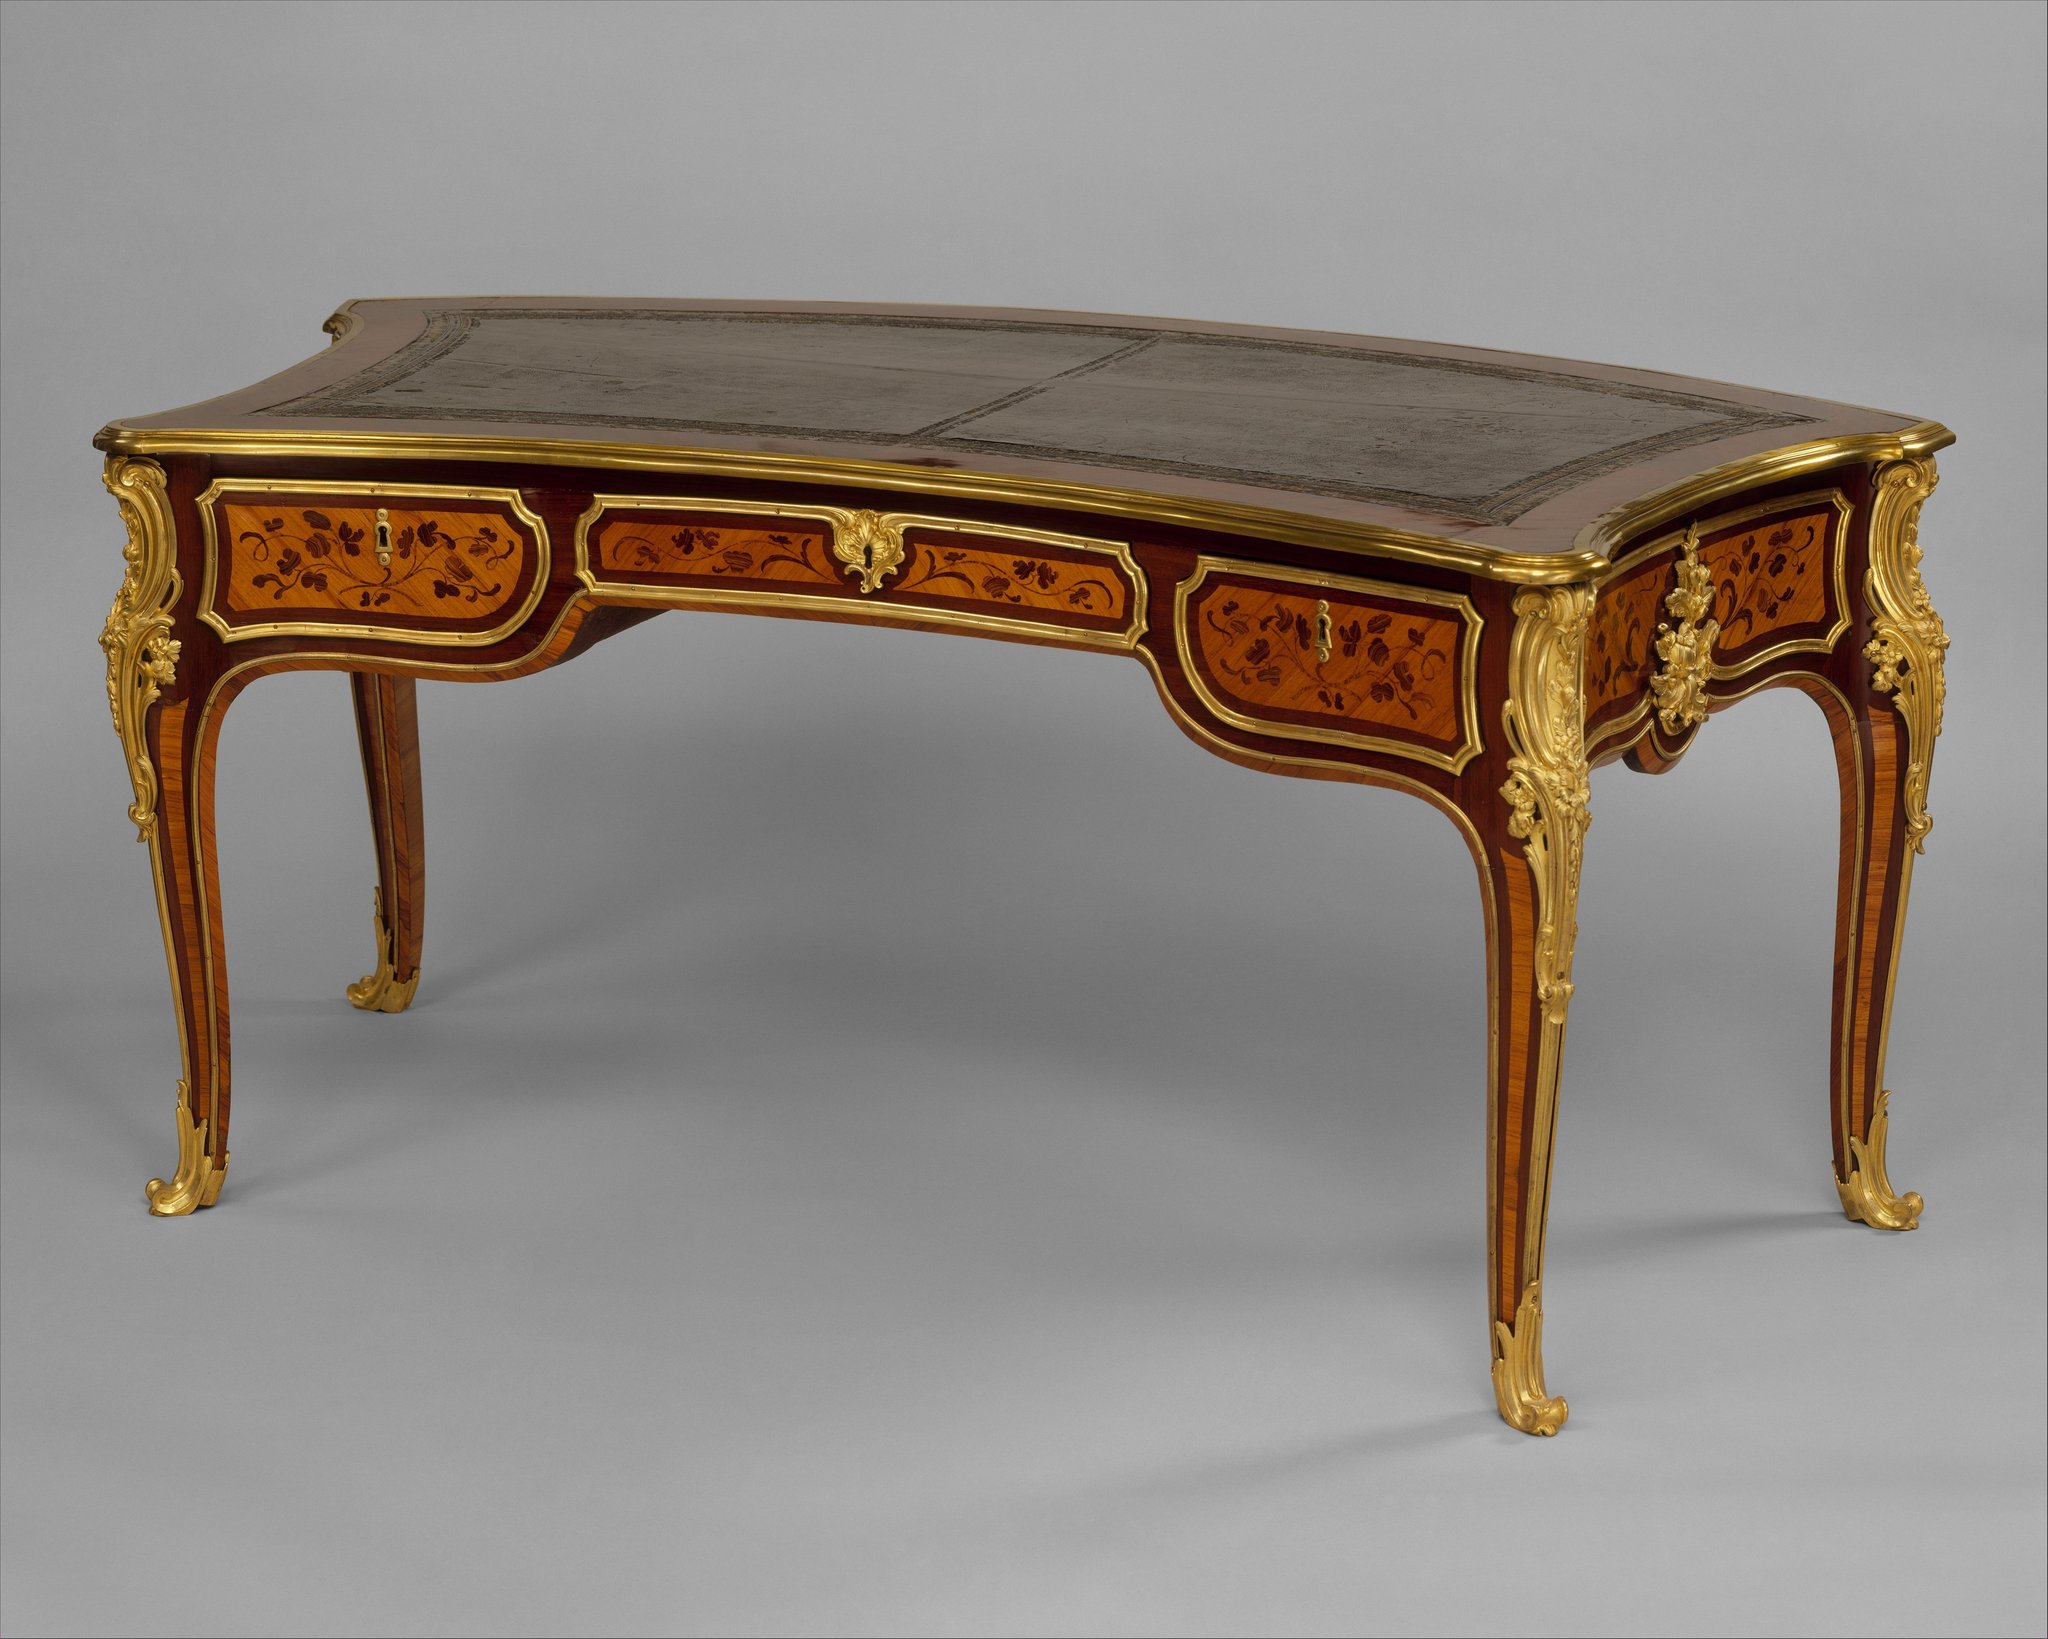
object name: writing table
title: Writing table (part of a set)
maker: joseph baumhauer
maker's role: maker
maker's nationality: french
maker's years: 1749-1772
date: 1770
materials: gilt, gilt bronze, leather, wood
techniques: tooling, veneering